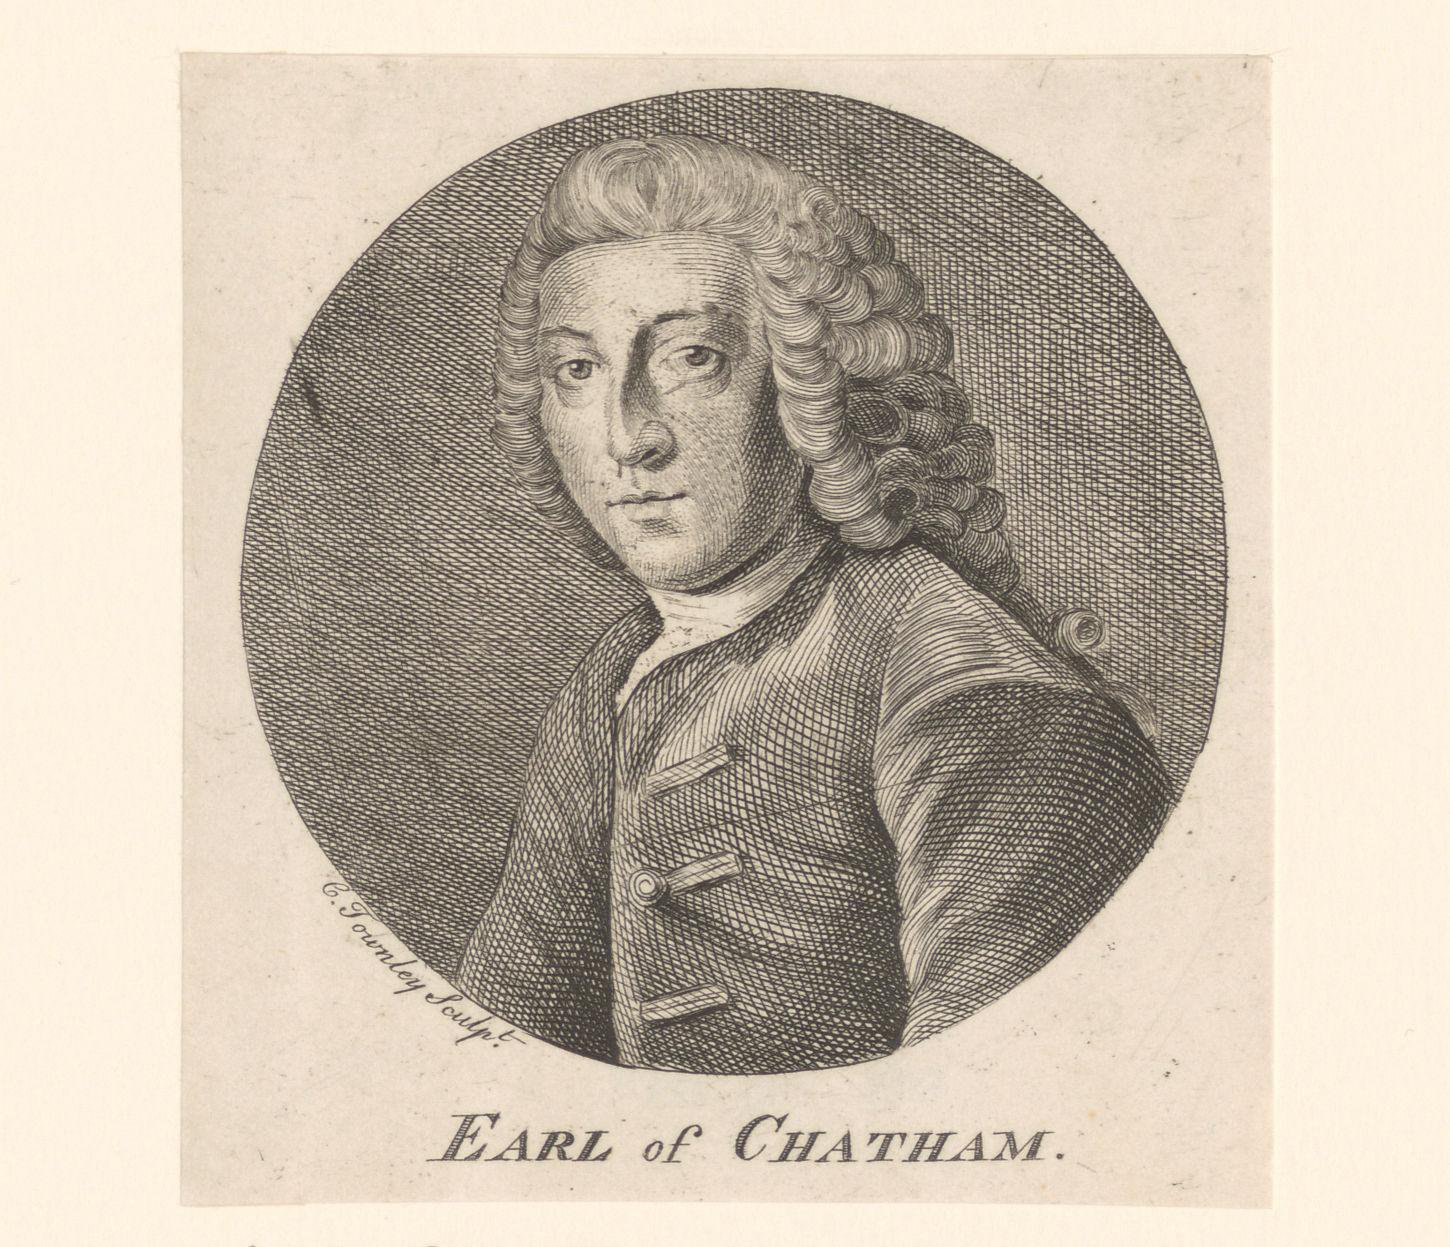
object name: print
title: Earl of Chatham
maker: charles townley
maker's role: print maker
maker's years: 1746-1800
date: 1756-1800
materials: paper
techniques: engraving, etching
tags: london, earl, politician, william pitt (i), historical persons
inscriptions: collector's mark: Lugt 2228